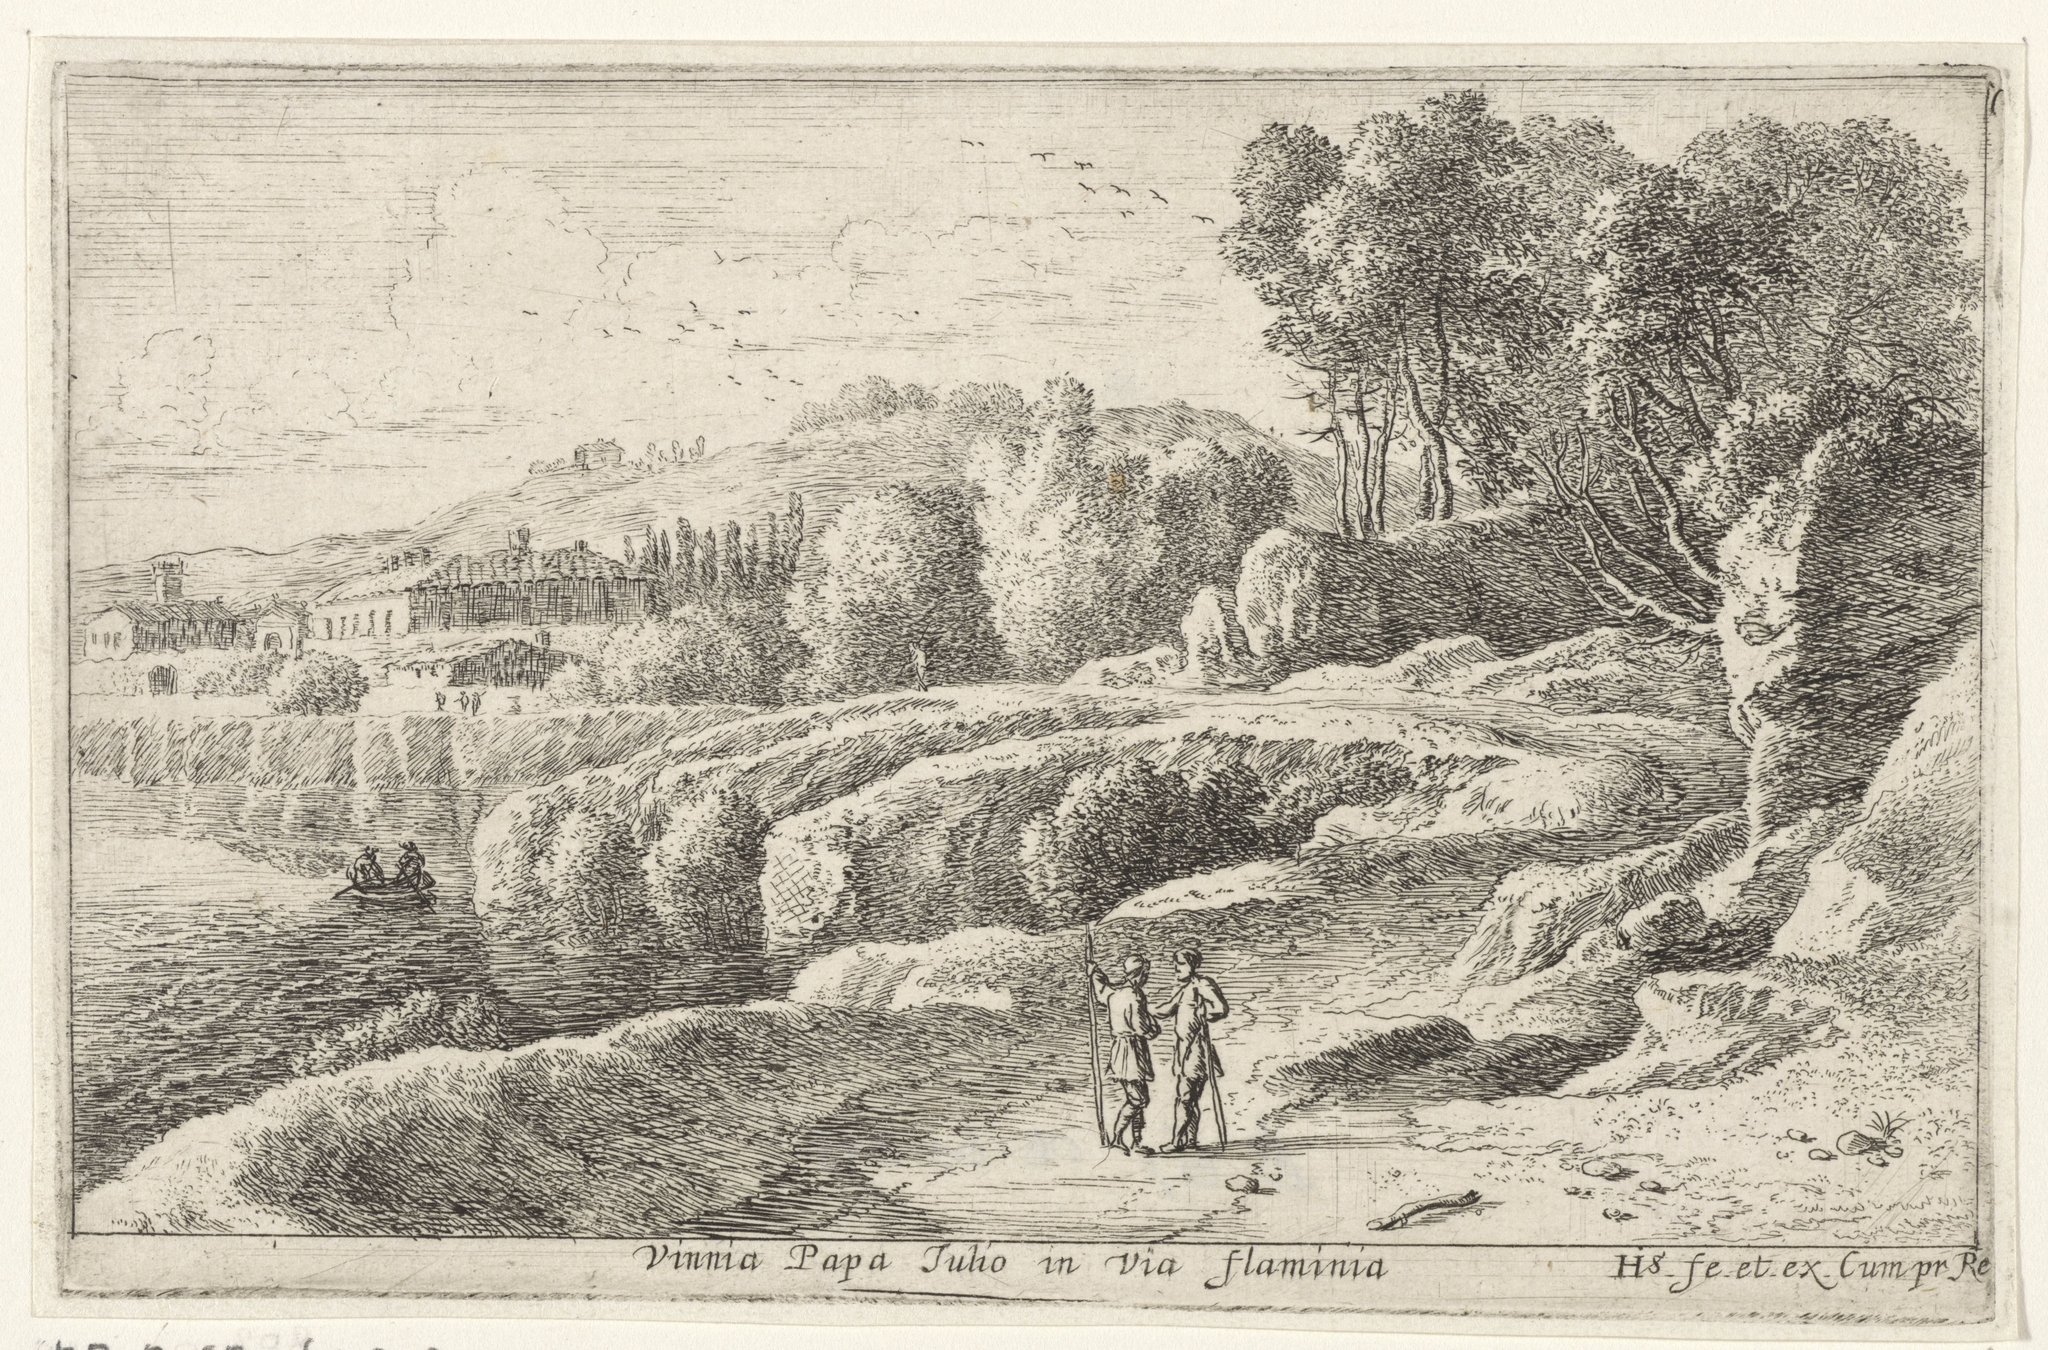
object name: print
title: Vinnia Papa Julio in Via flaminia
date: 1652-1653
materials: paper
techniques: etching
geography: paris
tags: landscapes, river, rowing-boat, canoe, etc., villa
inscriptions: collector's mark: Lugt 240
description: Aan de oever van de Tiber ligt Villa Giulia van paus Julius III. Er vaart een roeiboot met twee personen over de rivier en twee wandelaars staan tegenover elkaar op de Via Flaminia.